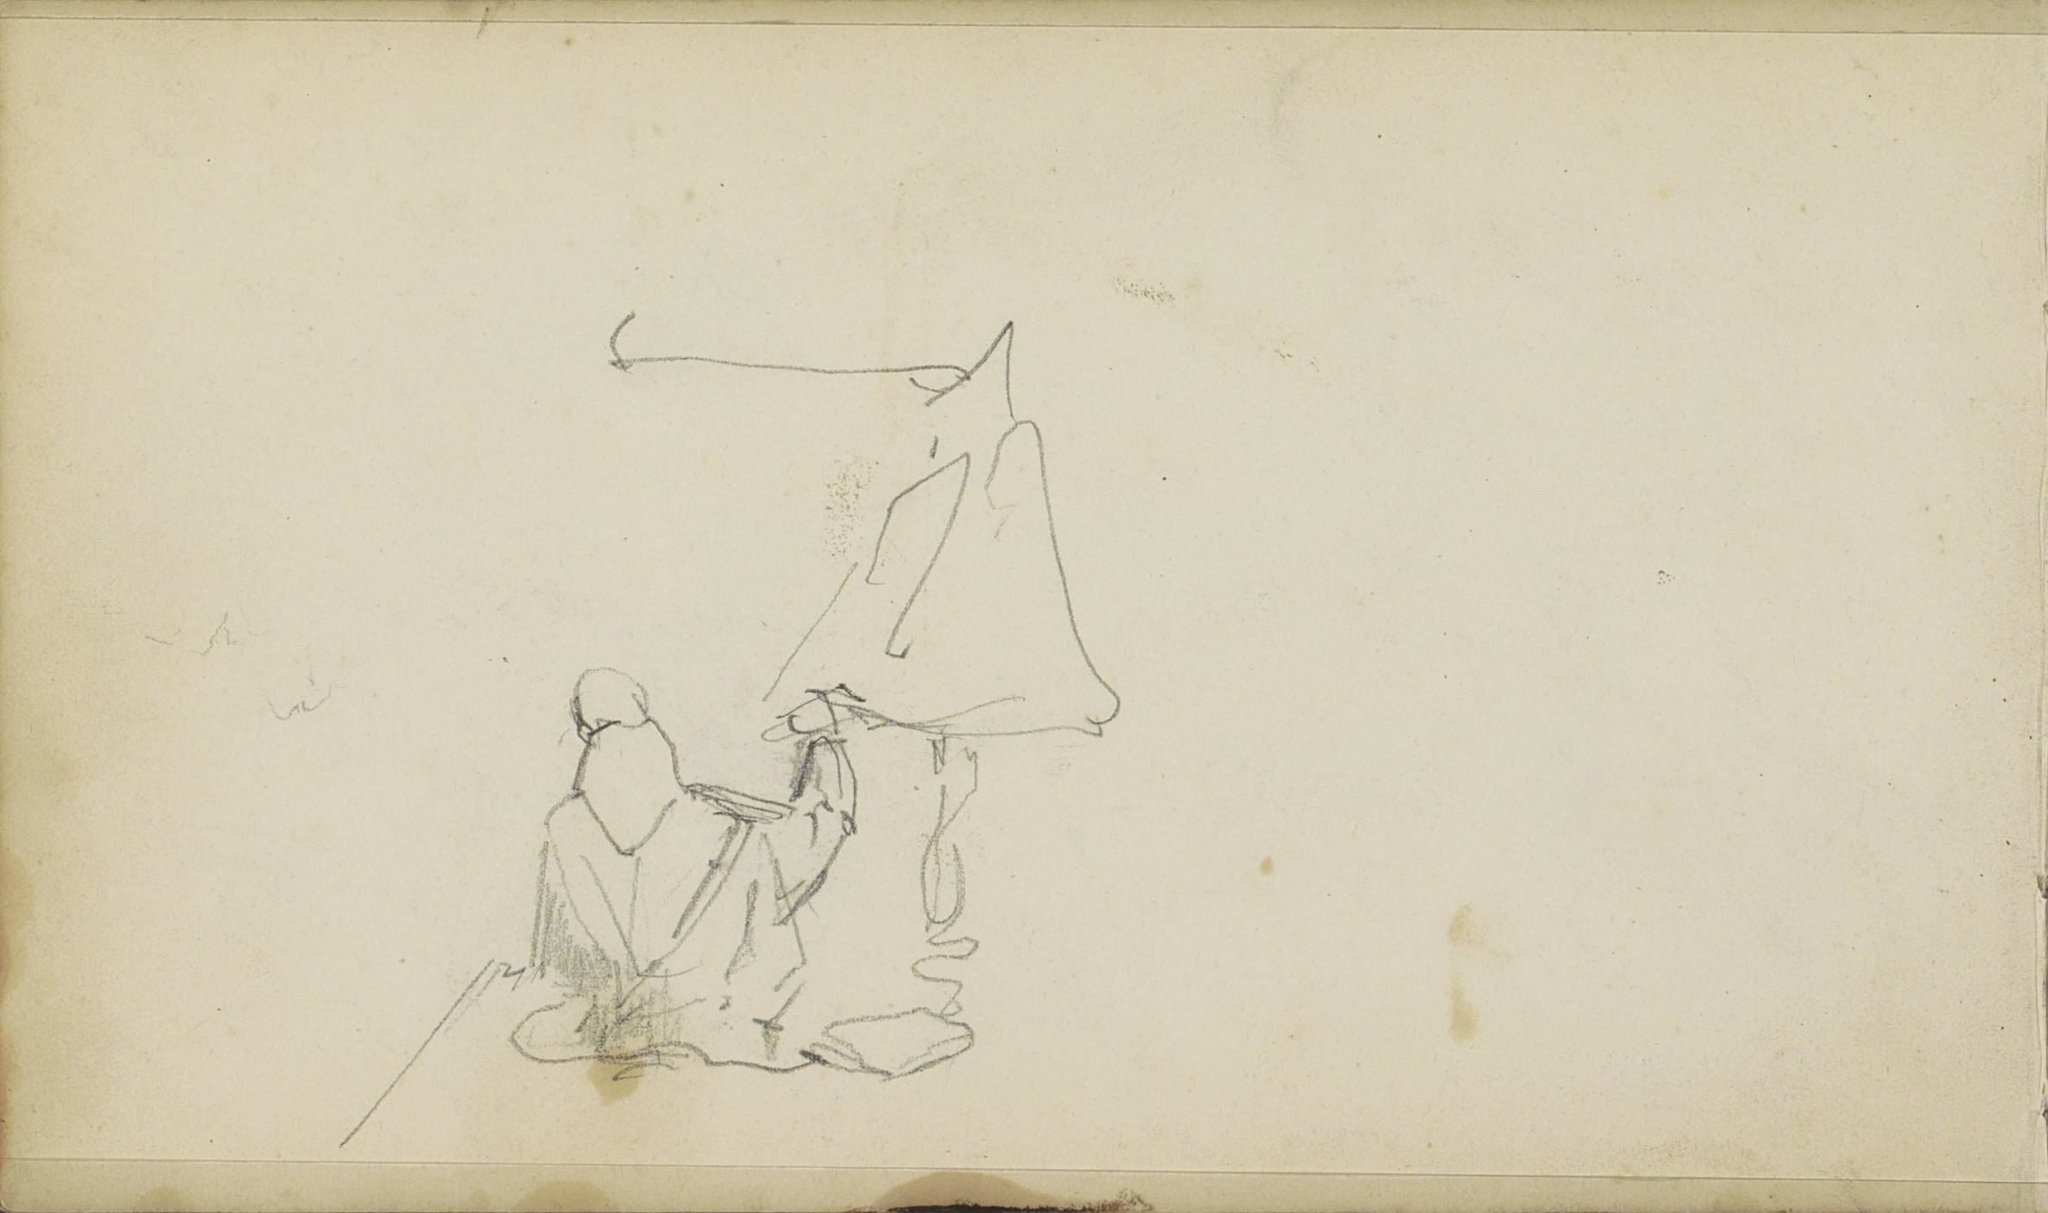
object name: sketchbook leaf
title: Figuurstudie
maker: johannes bosboom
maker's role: draughtsman, painter, print maker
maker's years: 1817-1891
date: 1845-1891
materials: paper, pencil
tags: anatomy (non-medical)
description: Blad 13 verso uit een schetsboek met 46 bladen.